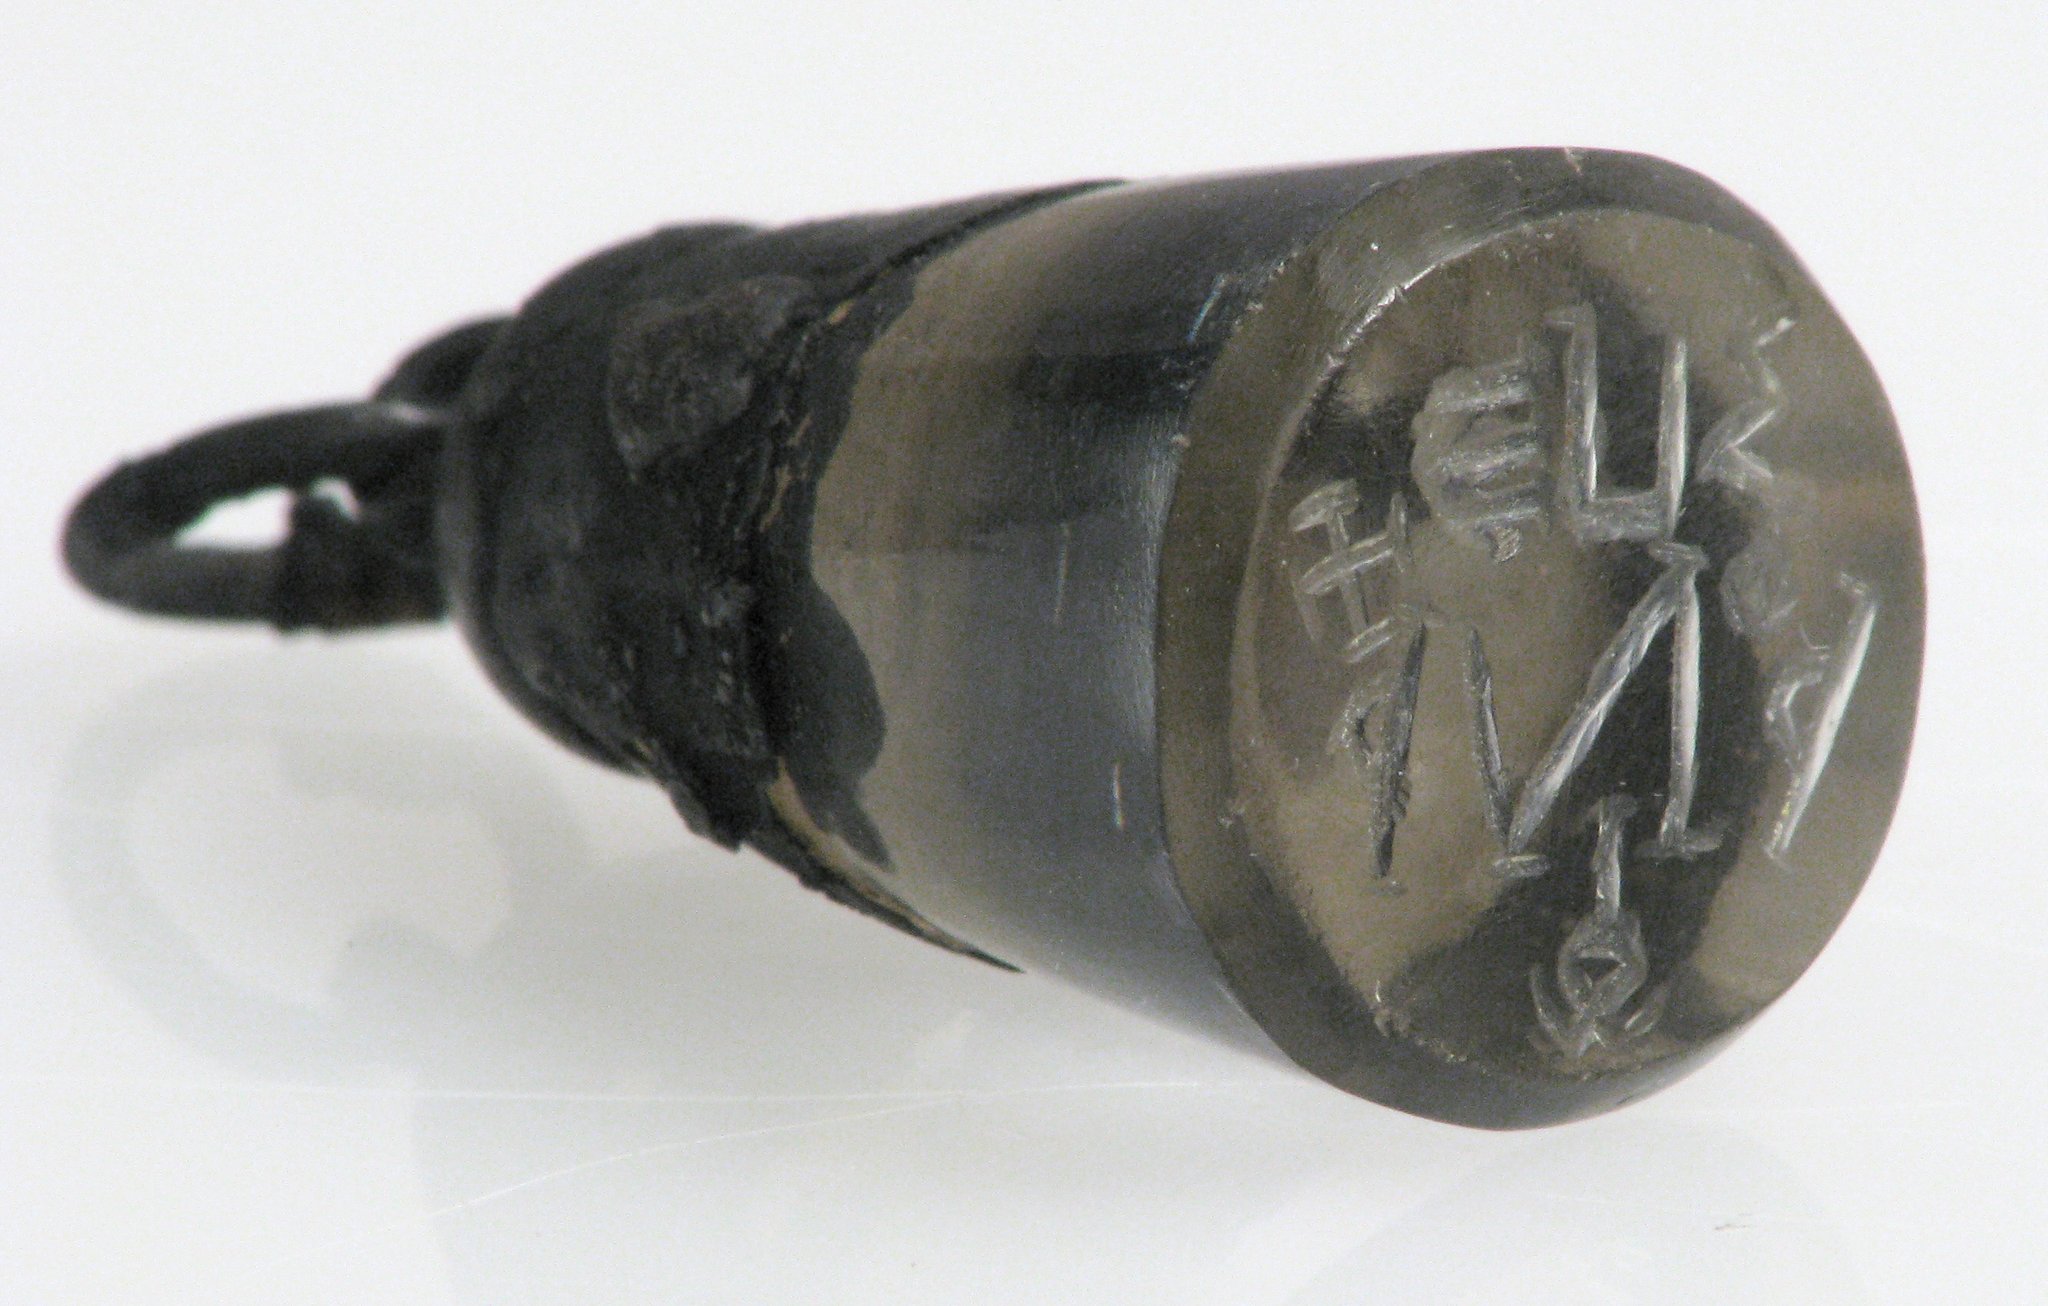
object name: seal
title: Rock Crystal Cone Seal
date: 501-700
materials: quartz, silver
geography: egypt